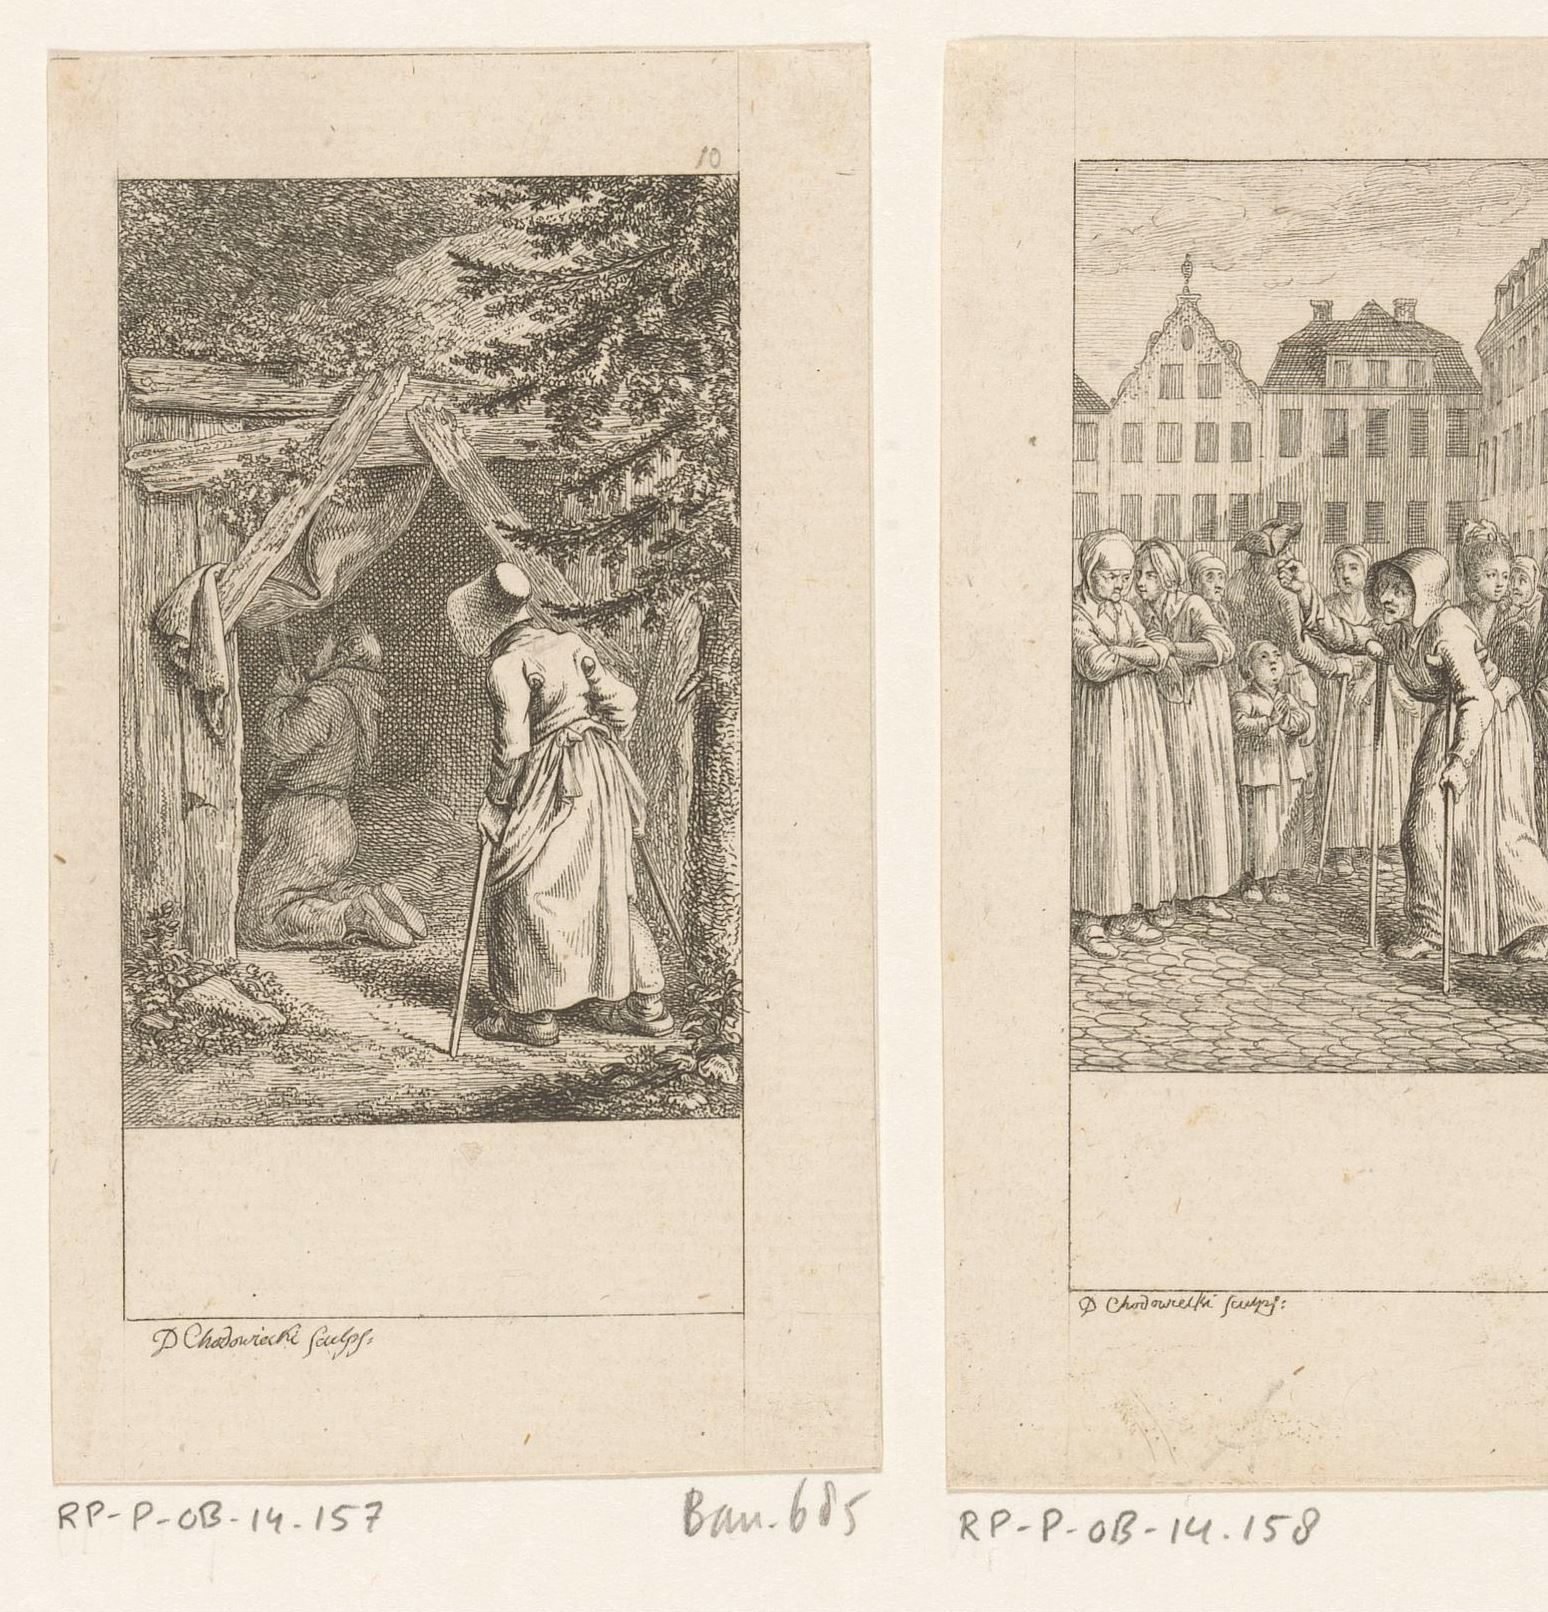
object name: print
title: Oude vrouw bij een heremiet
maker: daniel nikolaus chodowiecki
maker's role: draughtsman, print maker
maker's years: 1726-1801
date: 1779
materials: paper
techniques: etching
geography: berlin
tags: literature, crutches - aa - female human figure, anchorite, hermit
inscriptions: collector's mark: Lugt 2228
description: Tiende prent uit een serie van twaalf prenten die de 'Fabeln und Erzählungen' van Gotthold Ephraim Lessing illustreren. De scènes werden op een plaat geëtst. Een latere staat van deze serie is ook gebruikt in: Almanac de Gotha contenant diverses connoissances curieuses et utiles pour l'annee 1780. Gotha, C.W. Ettinger.